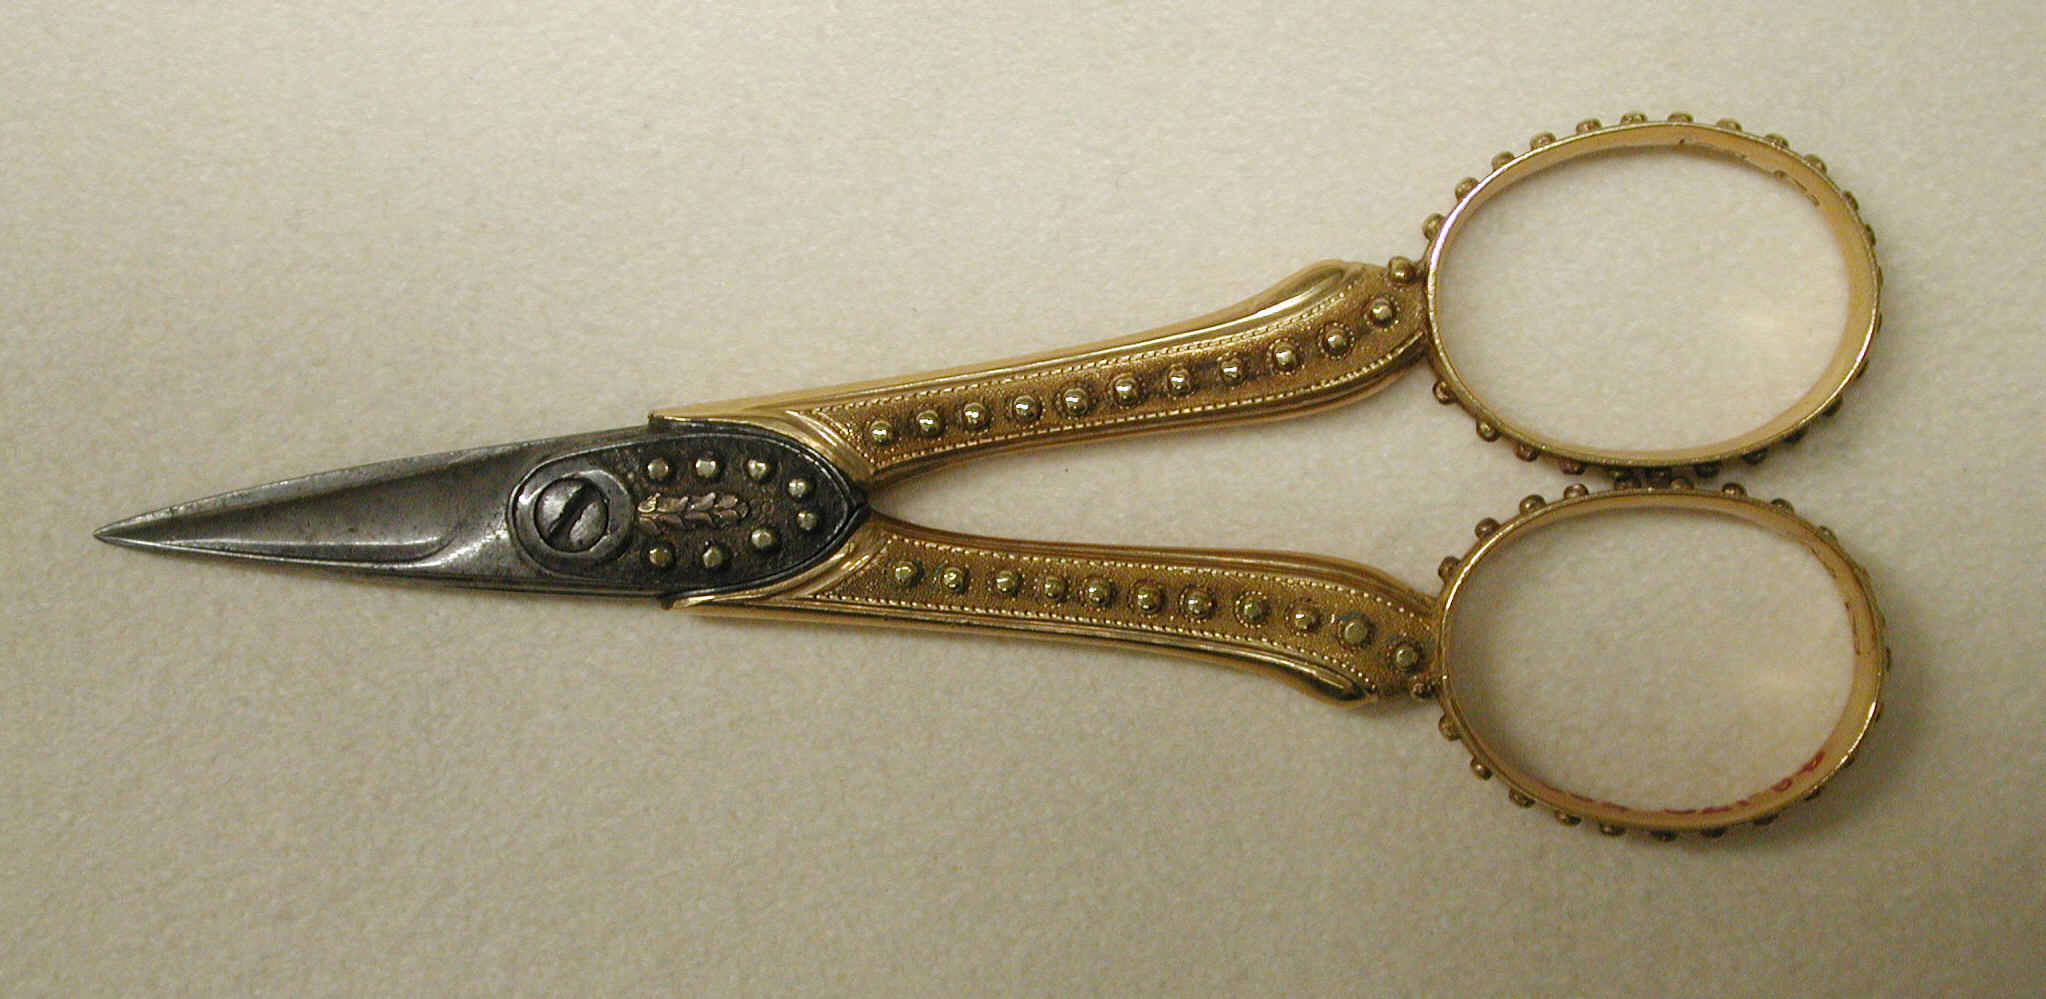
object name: scissors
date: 1780-1781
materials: gold, steel